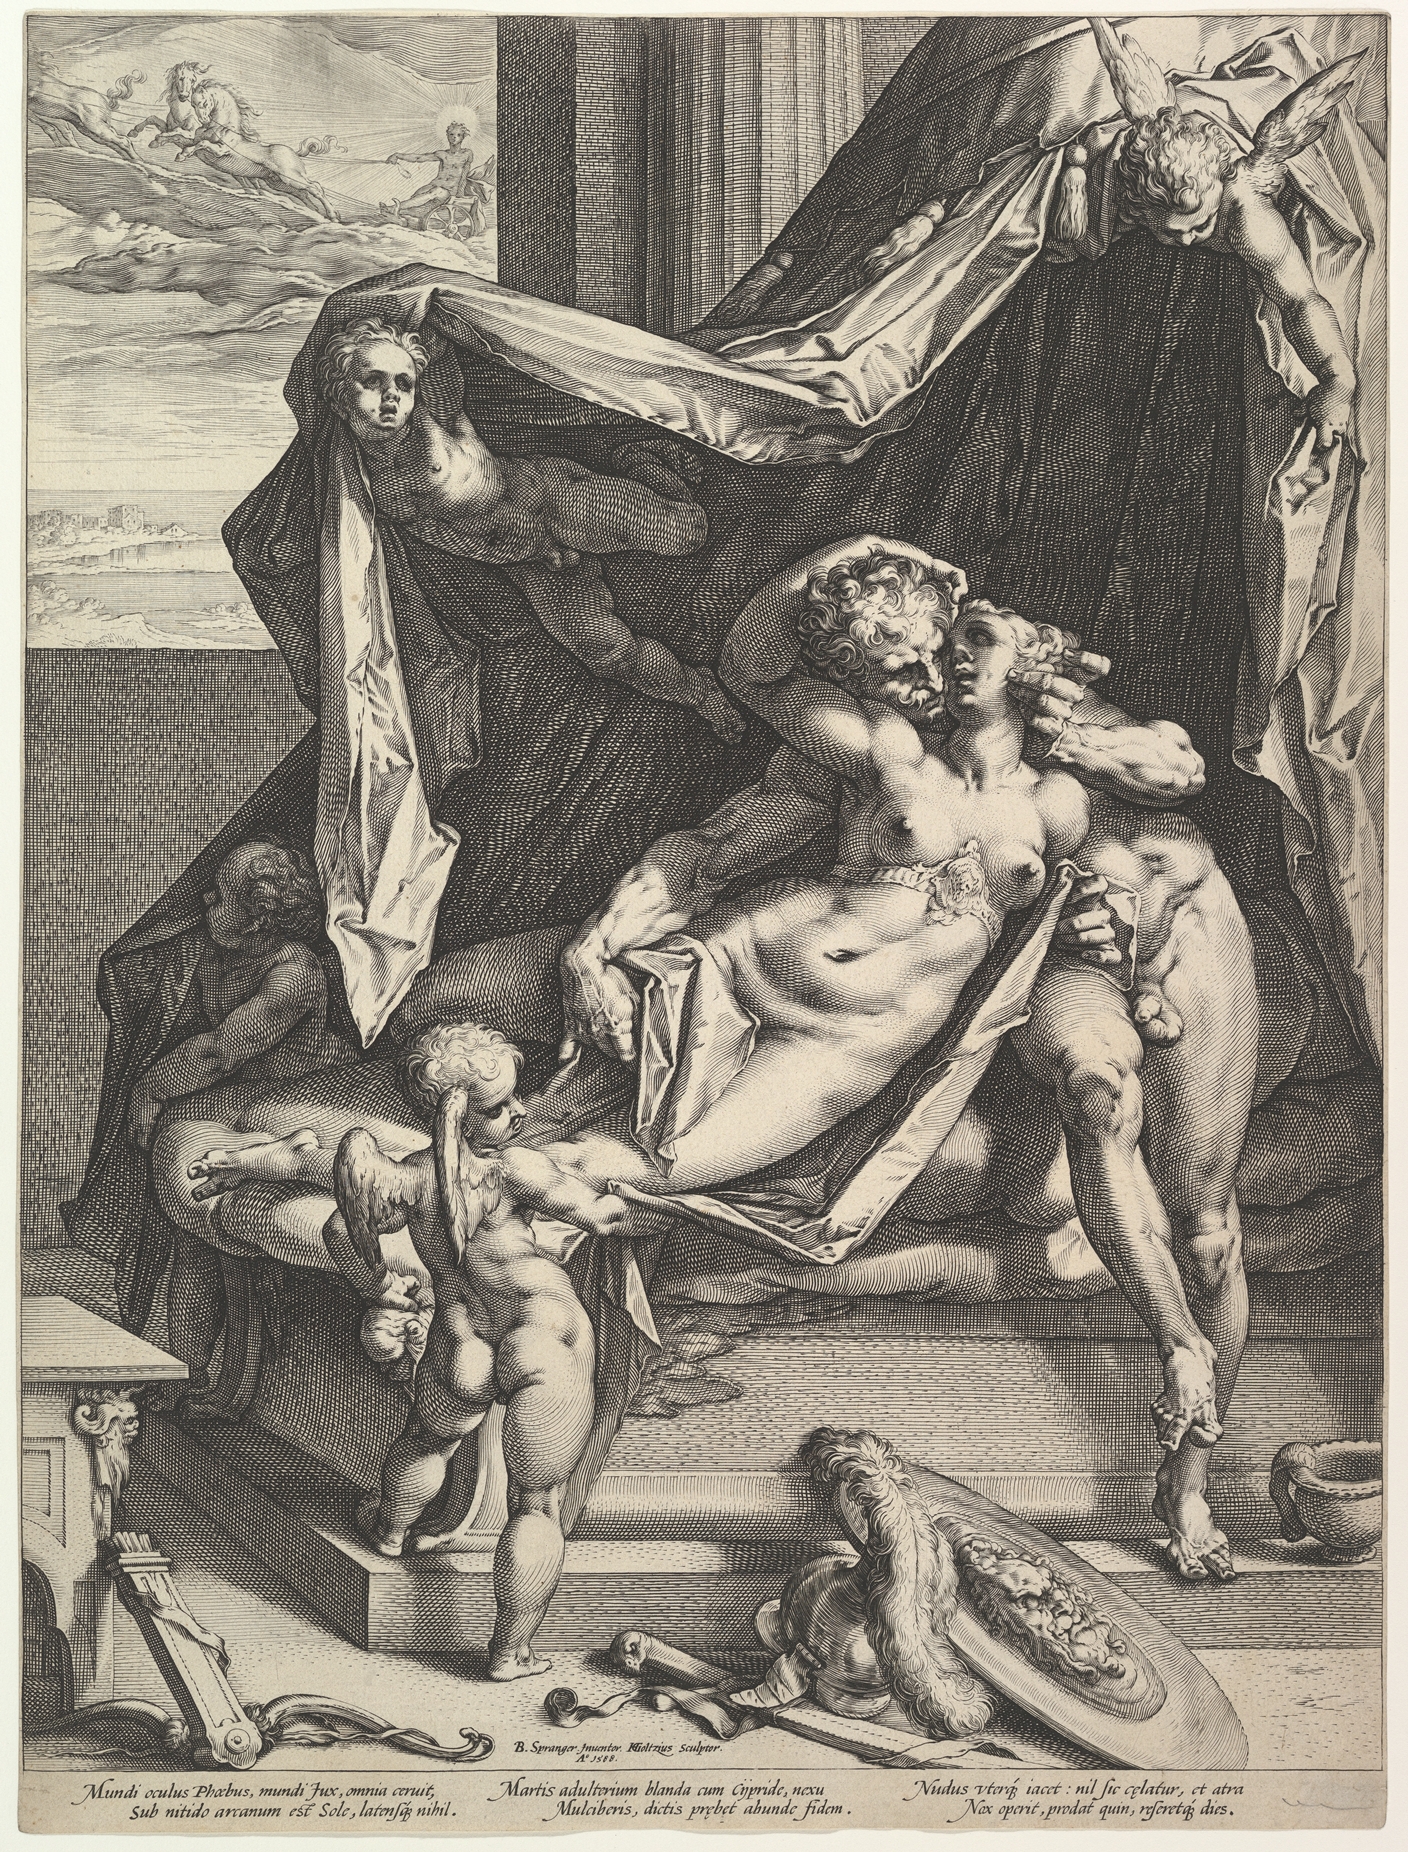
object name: print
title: Mars and Venus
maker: hendrick goltzius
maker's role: artist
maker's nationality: netherlandish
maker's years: 1558-1617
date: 1588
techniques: engraving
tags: bow and arrow,mars,venus,horses,angels